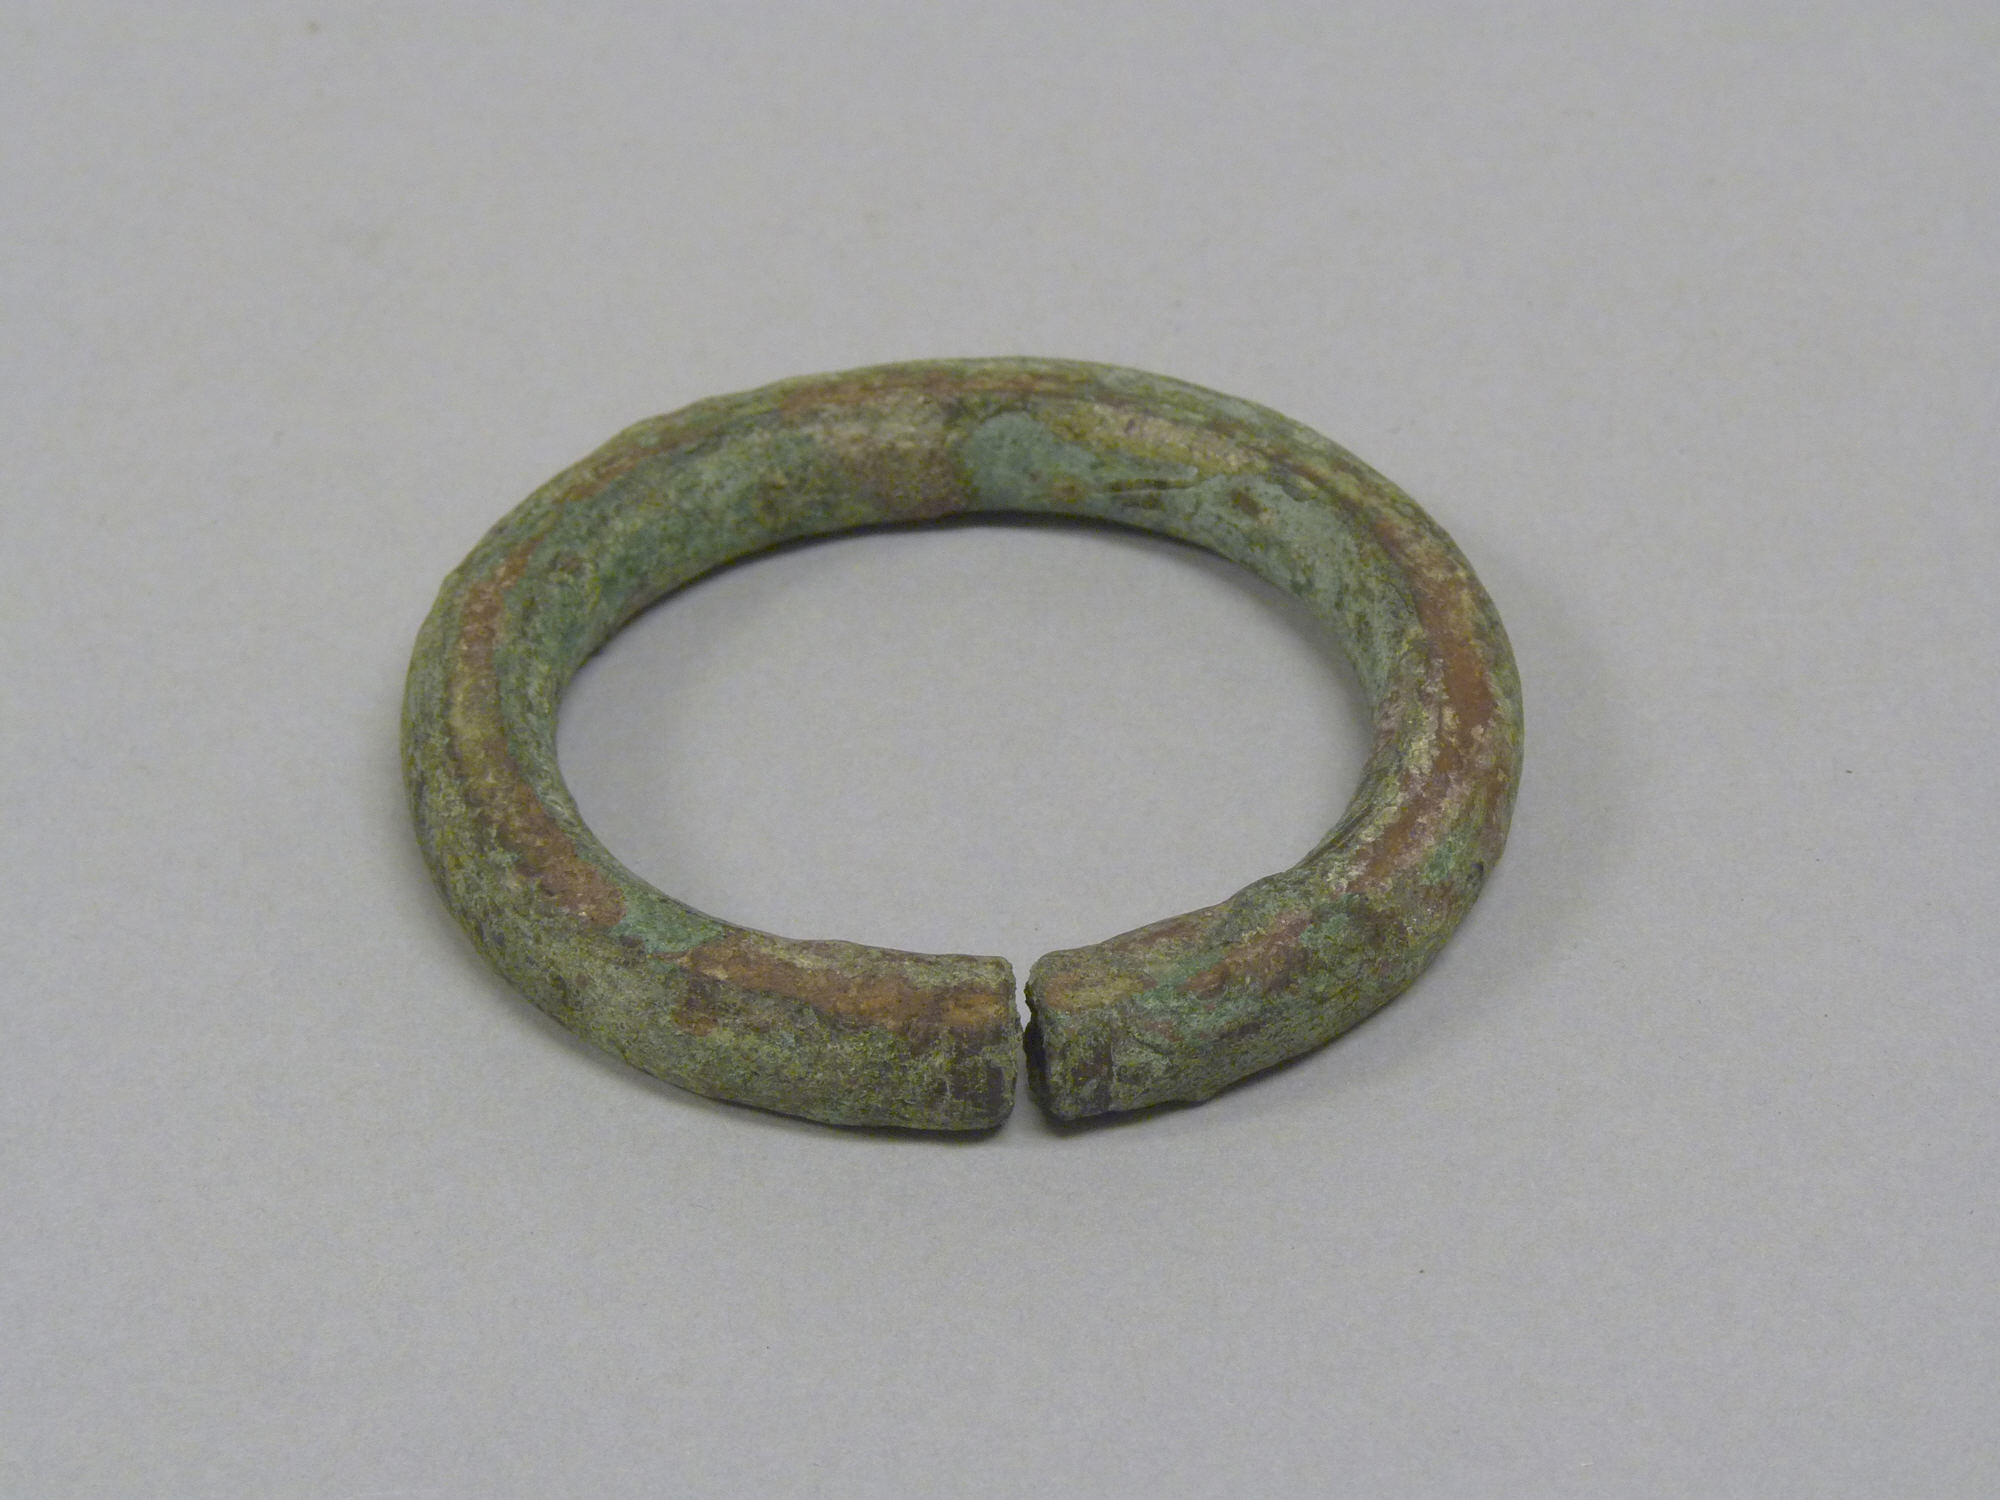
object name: bracelet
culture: thai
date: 500 BCE-300 CE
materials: bronze